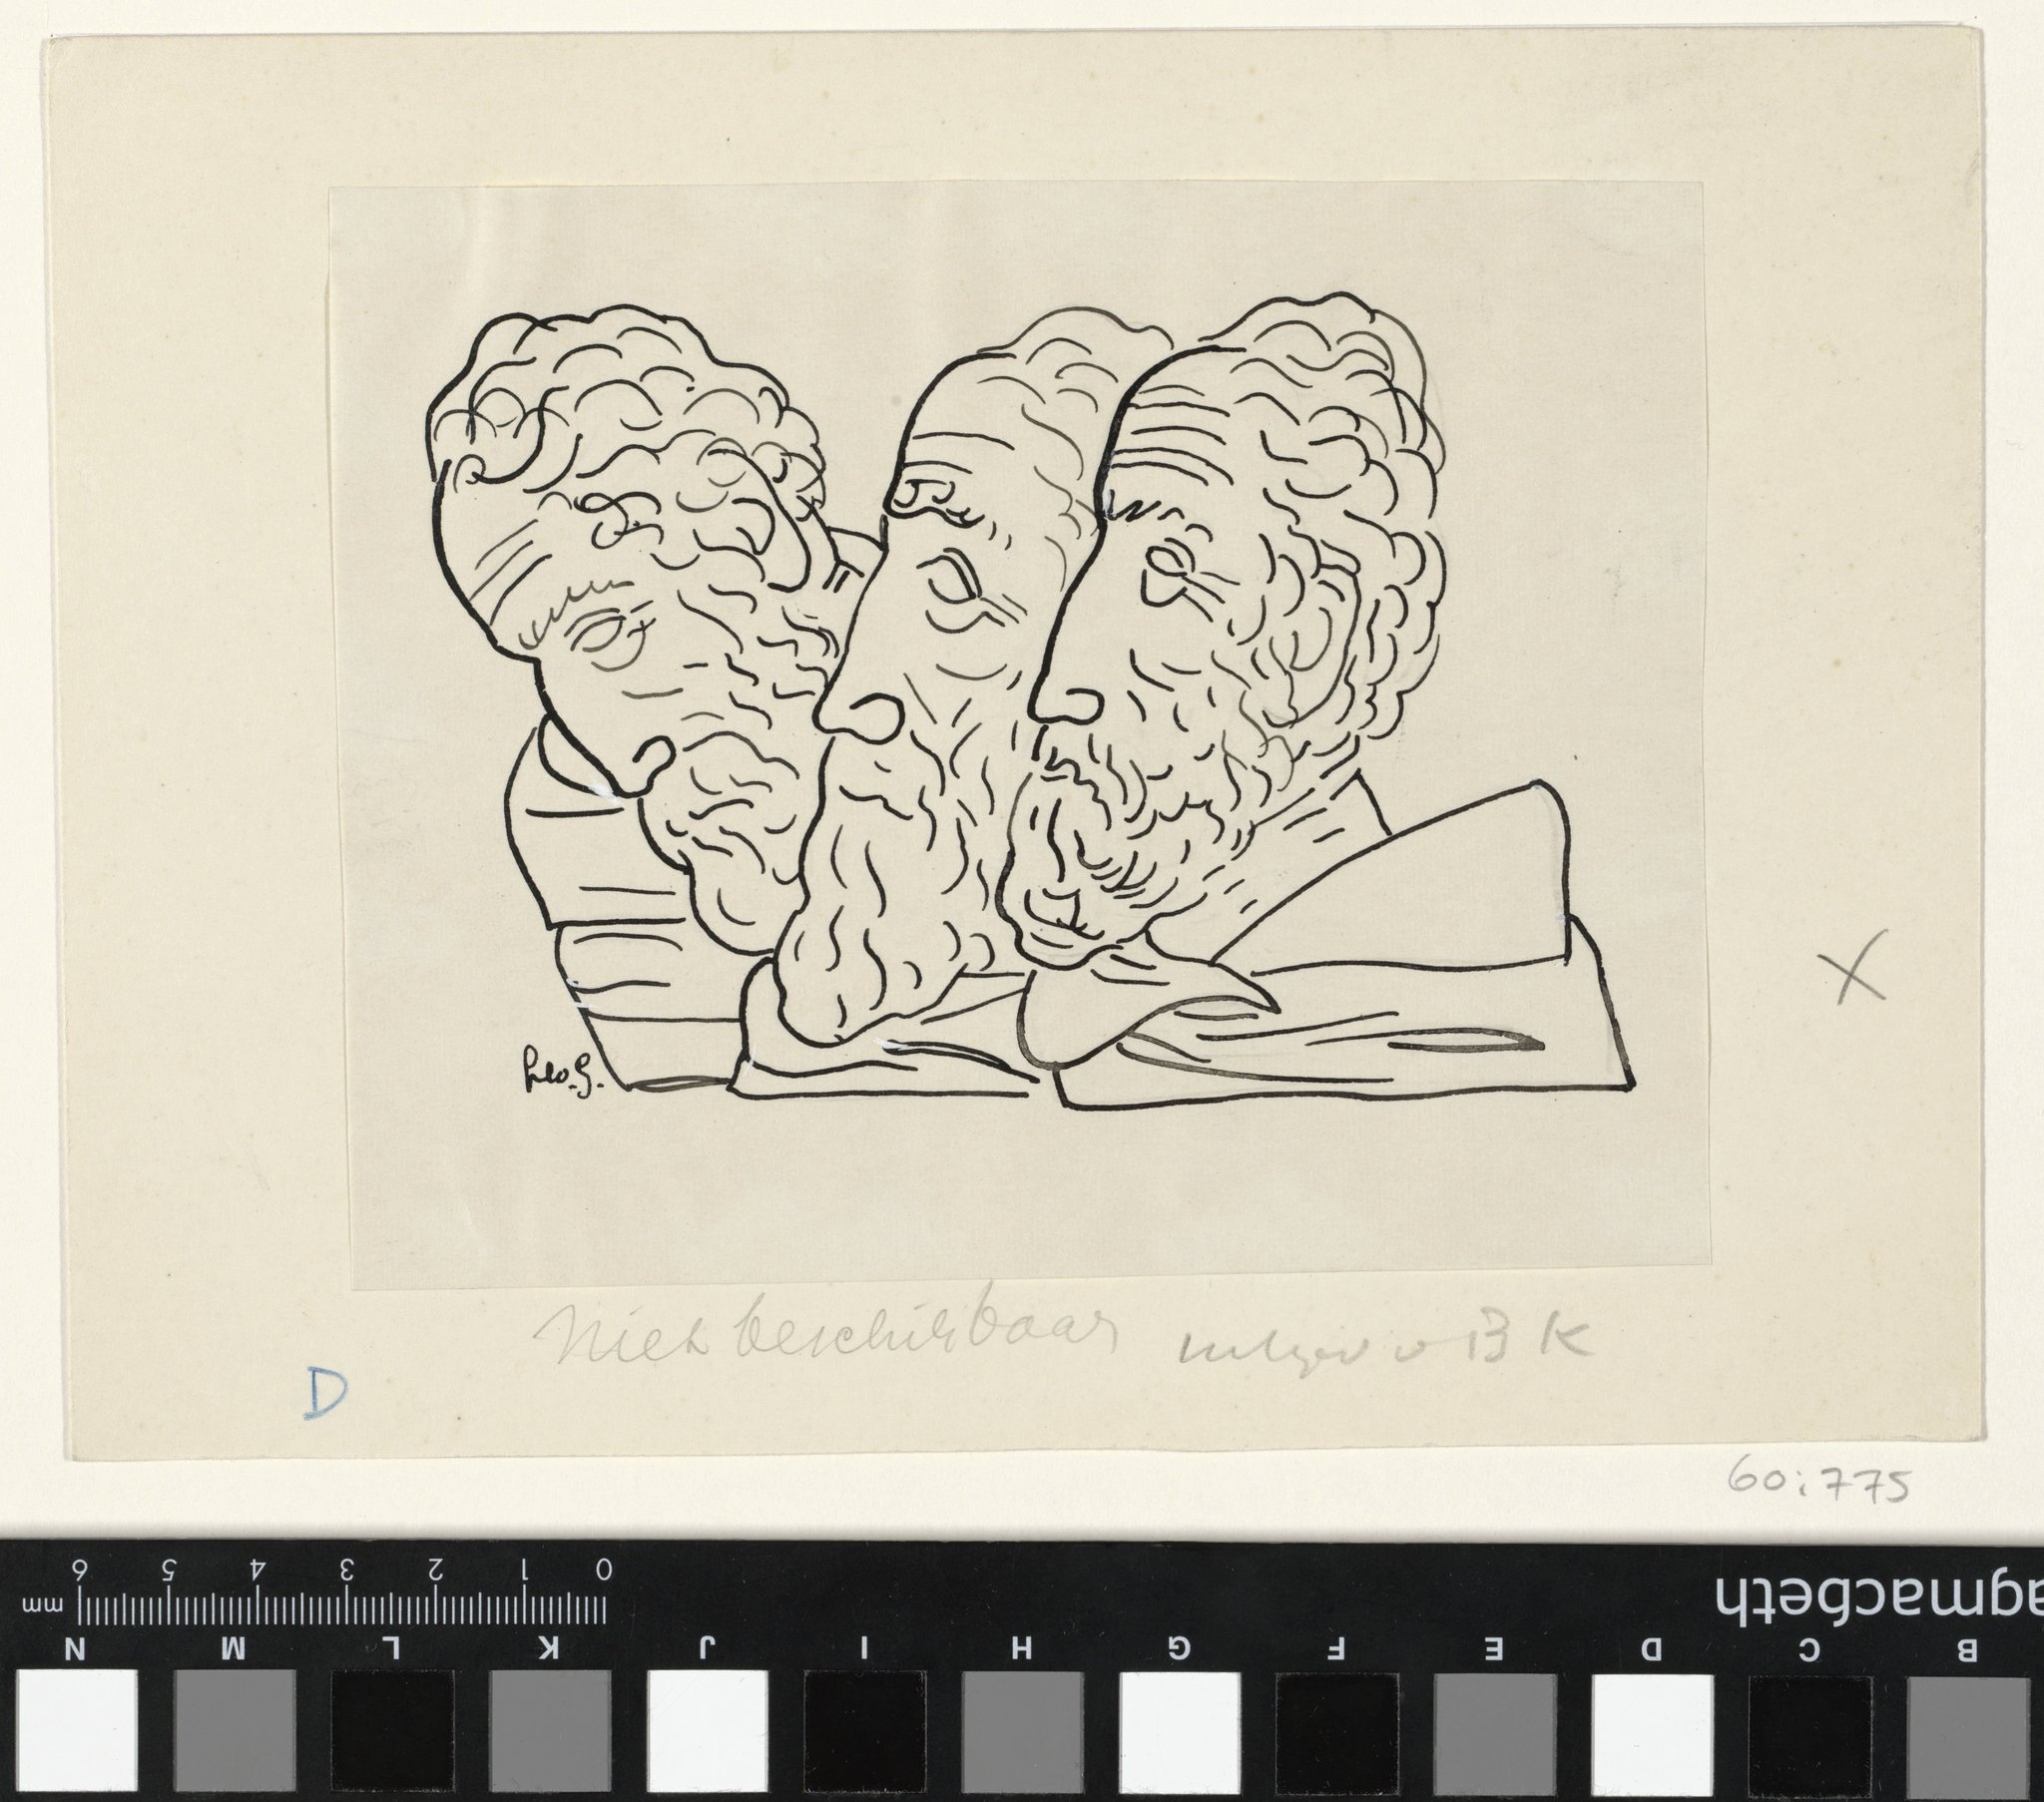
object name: design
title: Drie mannenhoofden met baard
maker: leo gestel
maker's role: draughtsman, print maker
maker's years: 1881-1941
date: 1891-1941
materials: paint, ink, paper, pencil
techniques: pen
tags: head (human), beard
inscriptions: collector's mark: Lugt 2228